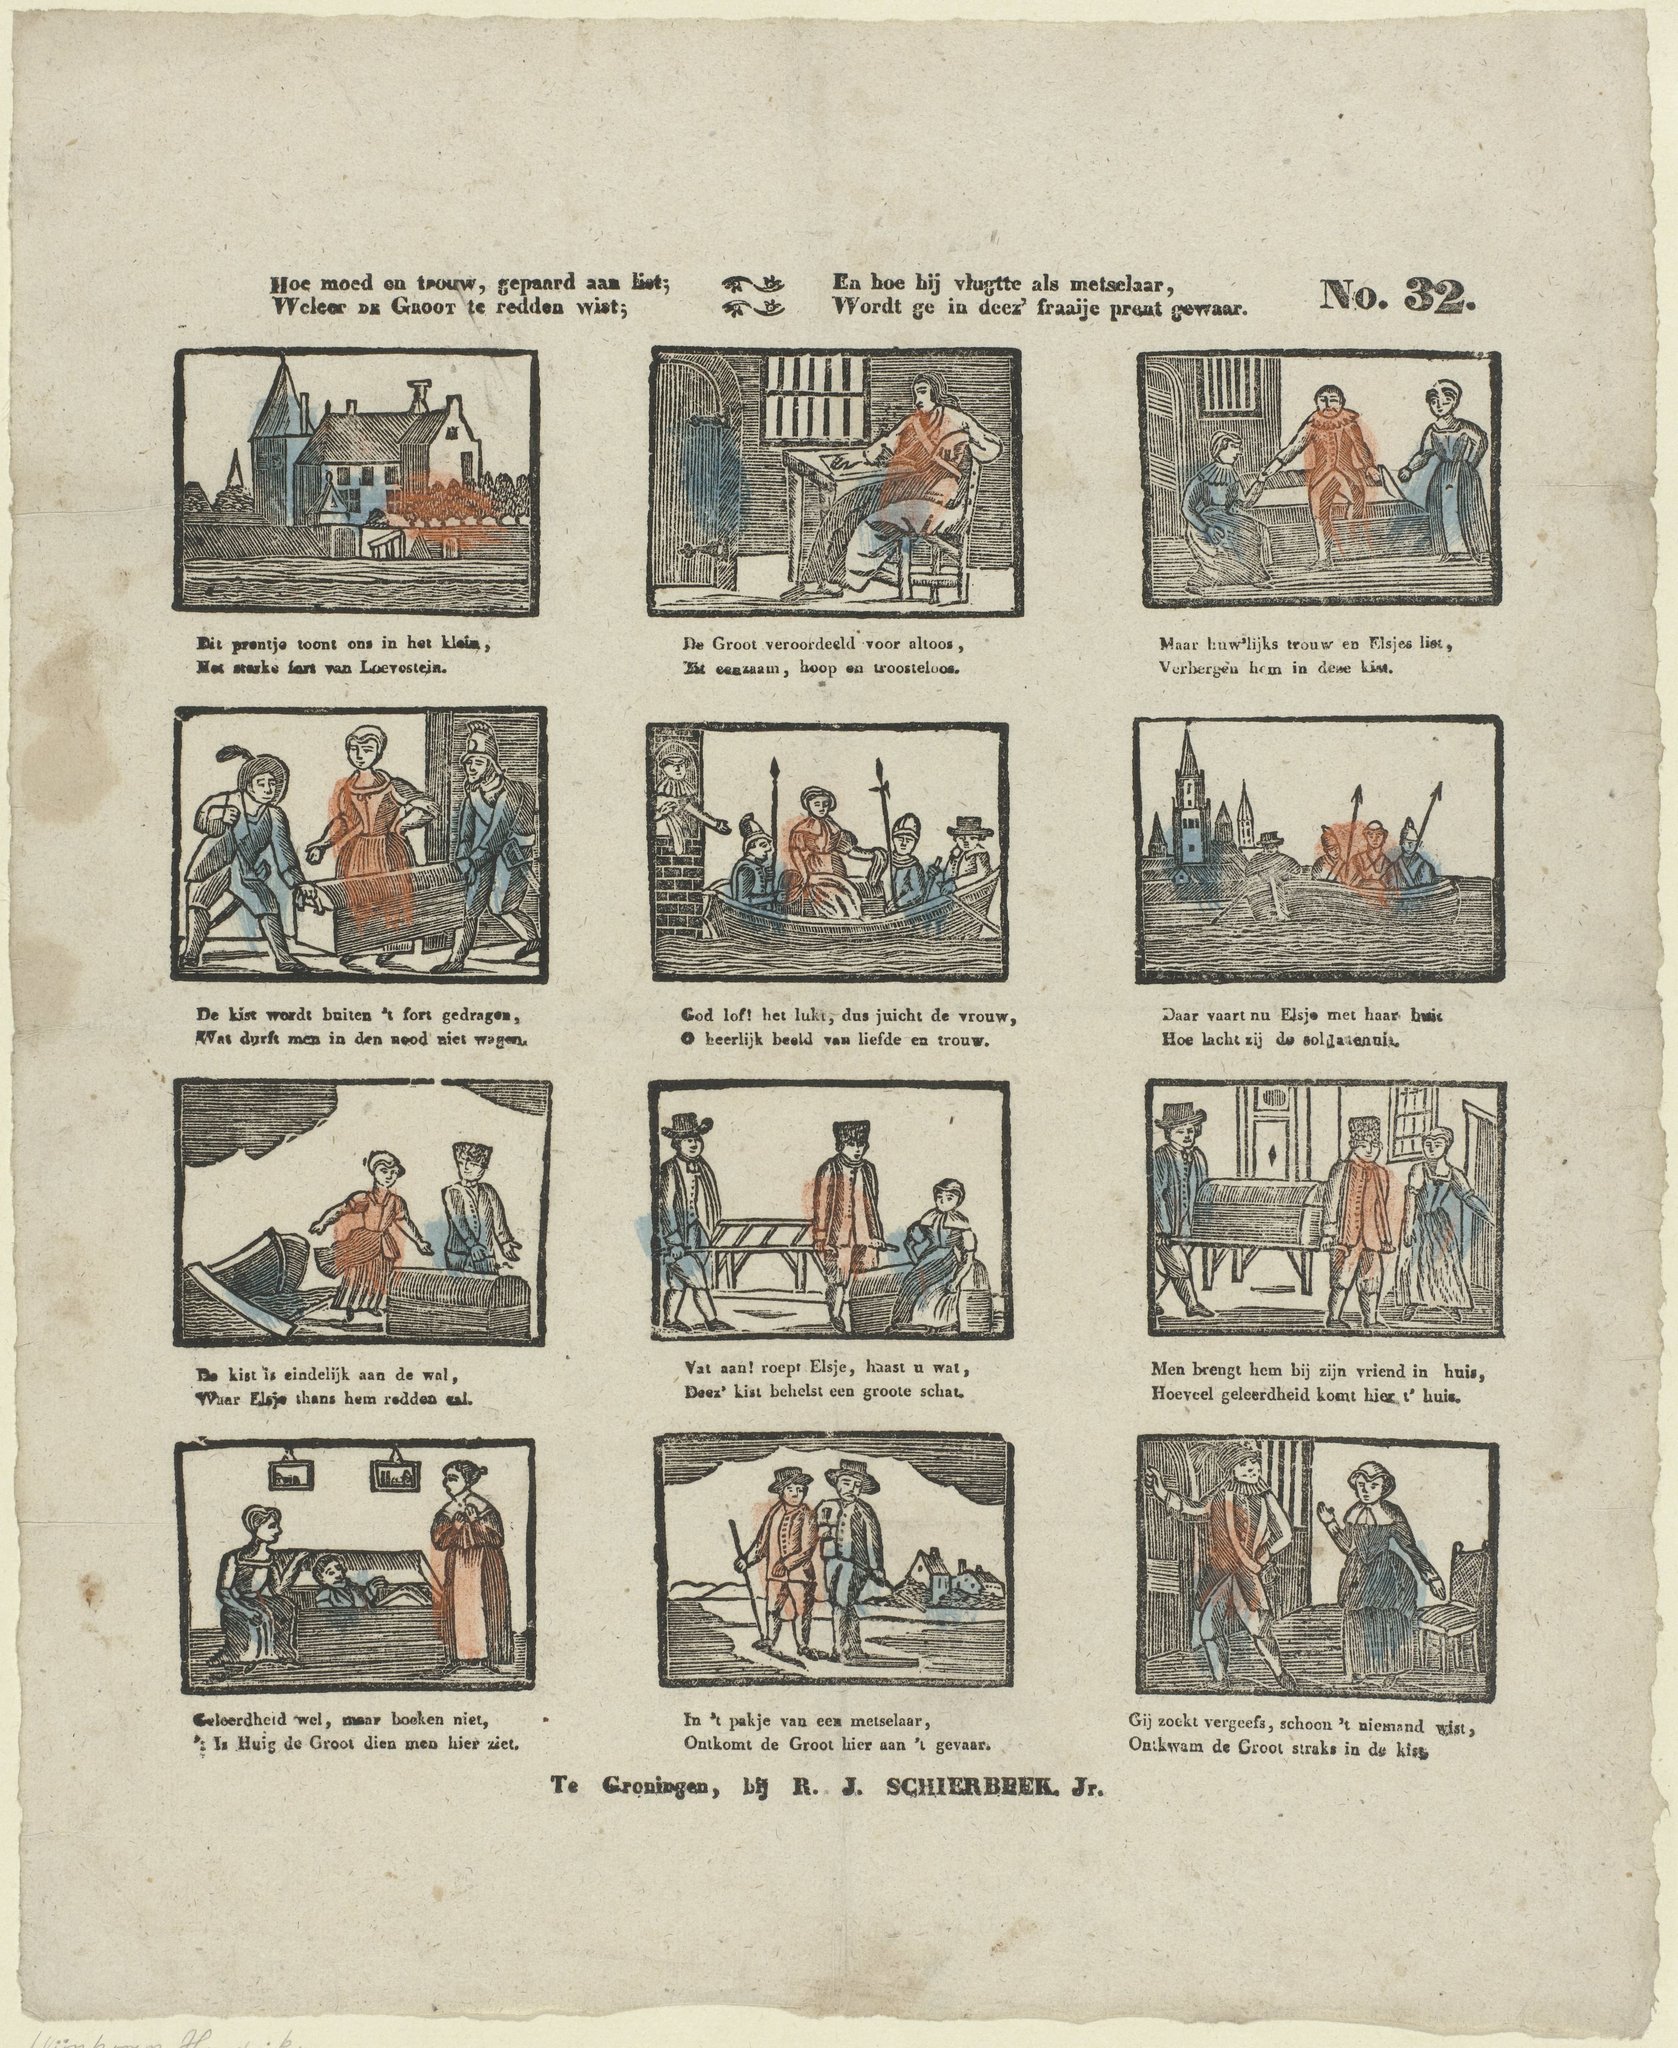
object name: popular print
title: Hoe moed en trouw, gepaard aan list; / Weleer De Groot te redden wist; / En hoe hij vlugtte als metselaar, / Wordt ge in deez' fraaije prent gewaar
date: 1832-1850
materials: paper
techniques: colour, letterpress printing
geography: groningen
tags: delft, hugo de groot, escape, escape attempts, loevestein castle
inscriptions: collector's mark: Lugt 2760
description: Blad met 12 voorstellingen over de ontsnapping van Hugo de Groot uit Slot Loevestein. Onder elke afbeelding een tweeregelig vers. Genummerd rechtsboven: No. 32.